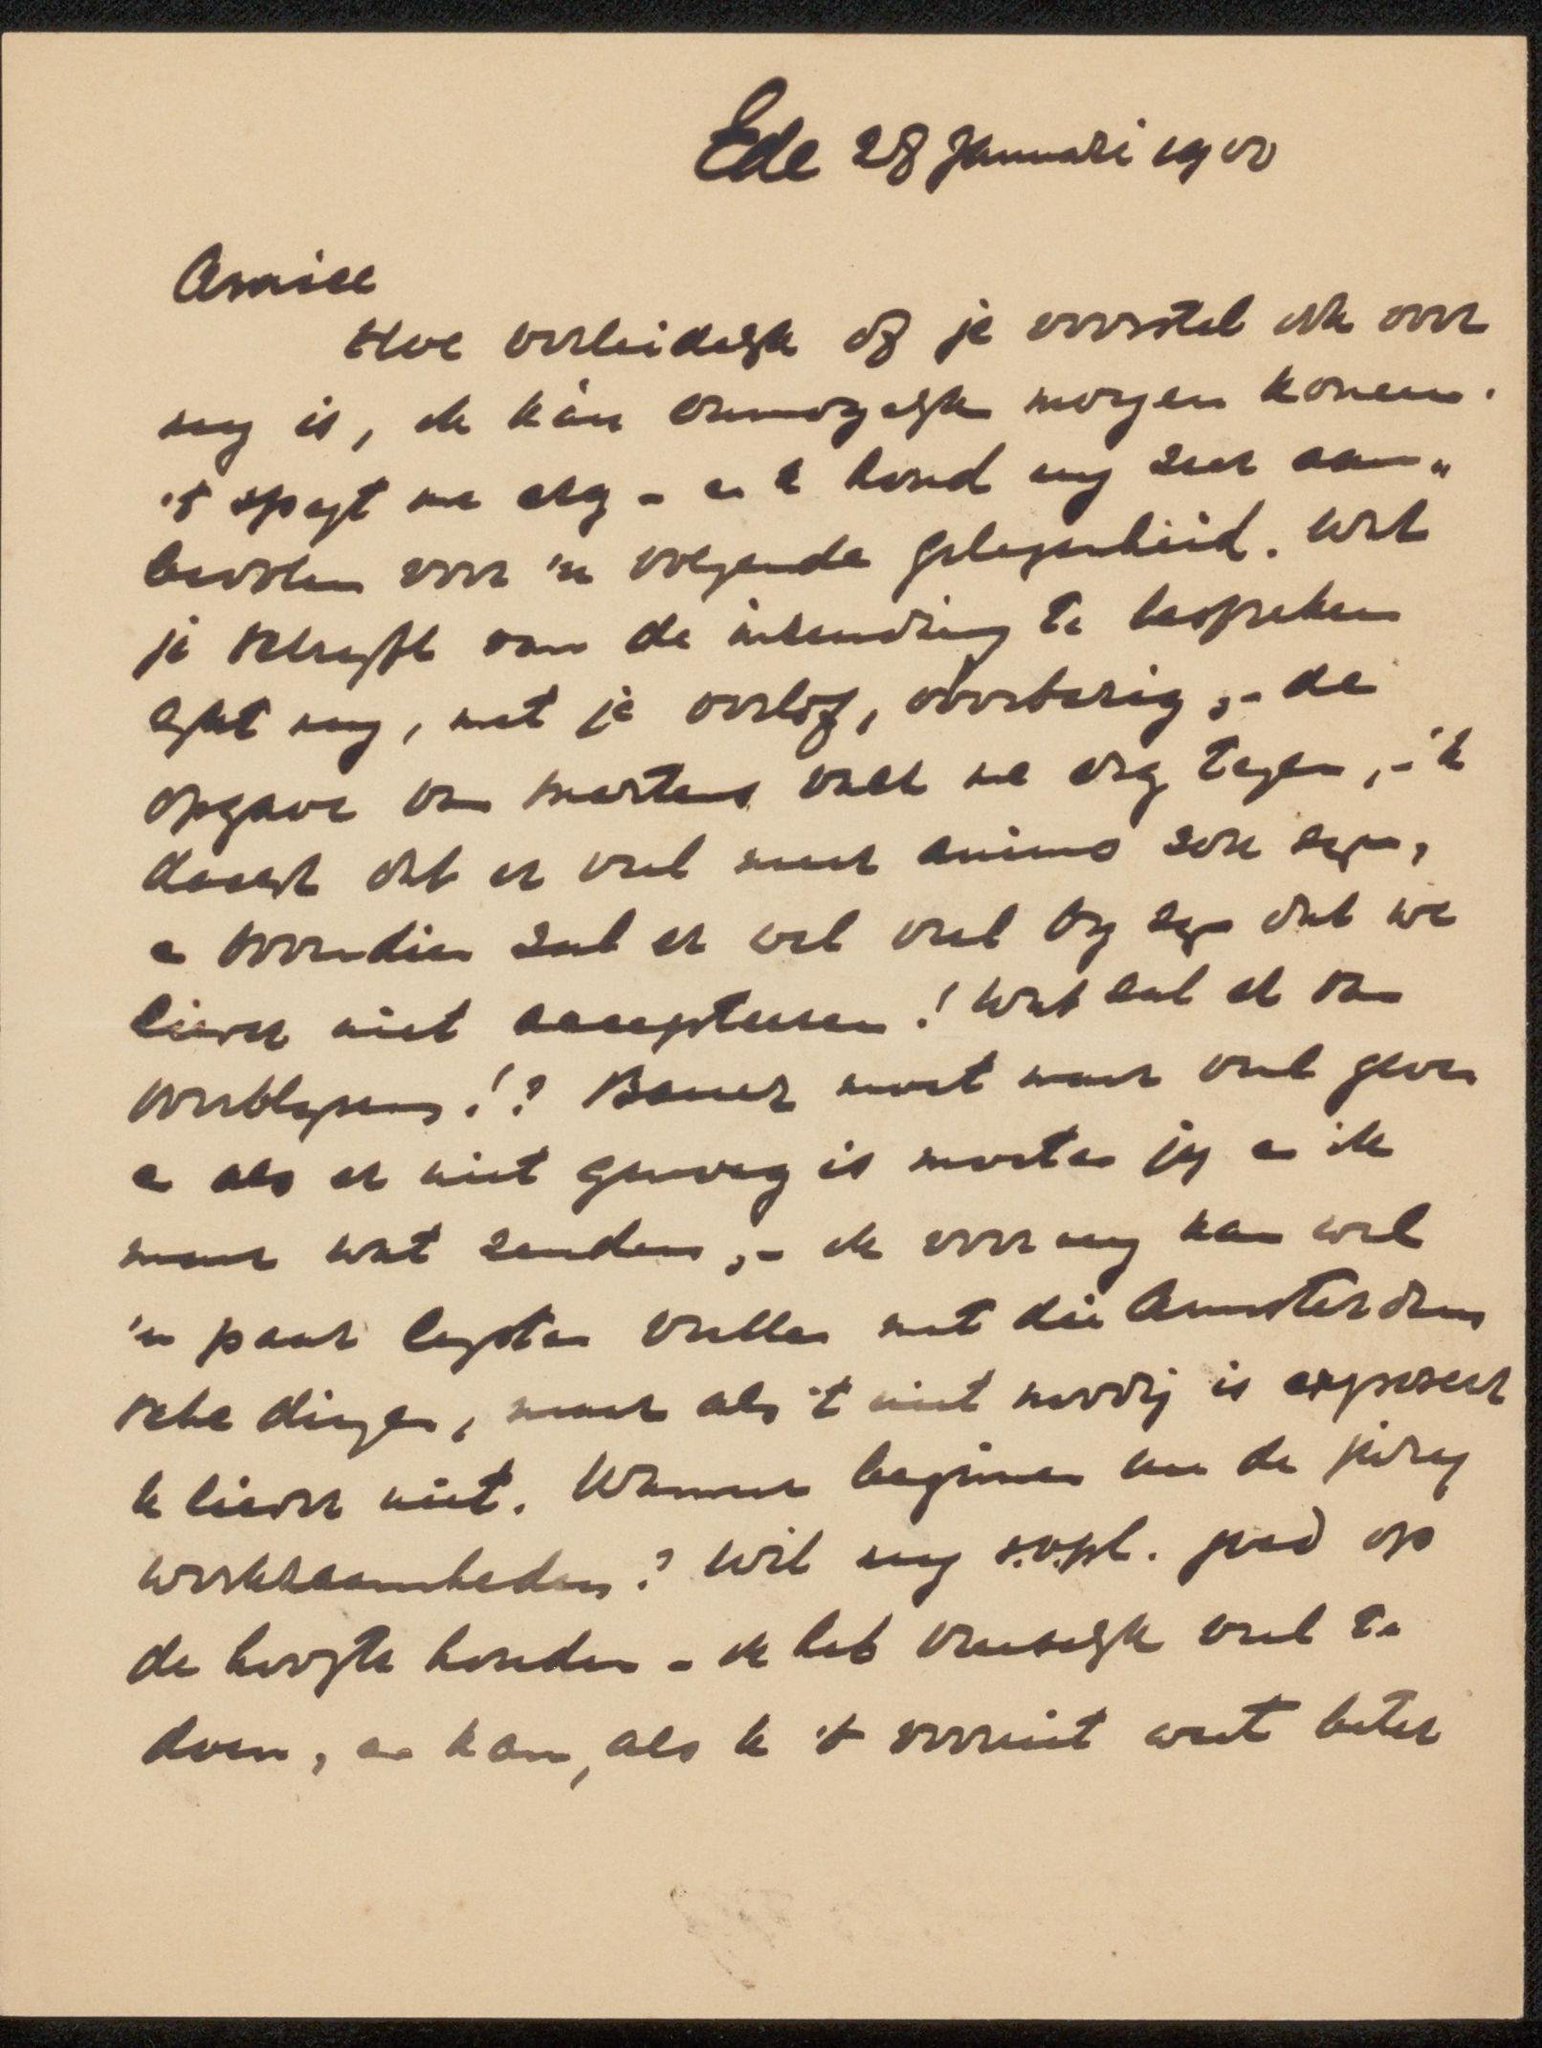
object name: letter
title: Brief aan Philip Zilcken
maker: willem witsen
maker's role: draughtsman, painter, print maker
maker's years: 1860-1923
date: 1900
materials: ink, paper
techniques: pen, writing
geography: ede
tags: willy martens, marius bauer, painter, draughtsman, philip zilcken, exhibition ~ art, amsterdam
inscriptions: watermark, collector's mark: ‘RPK’